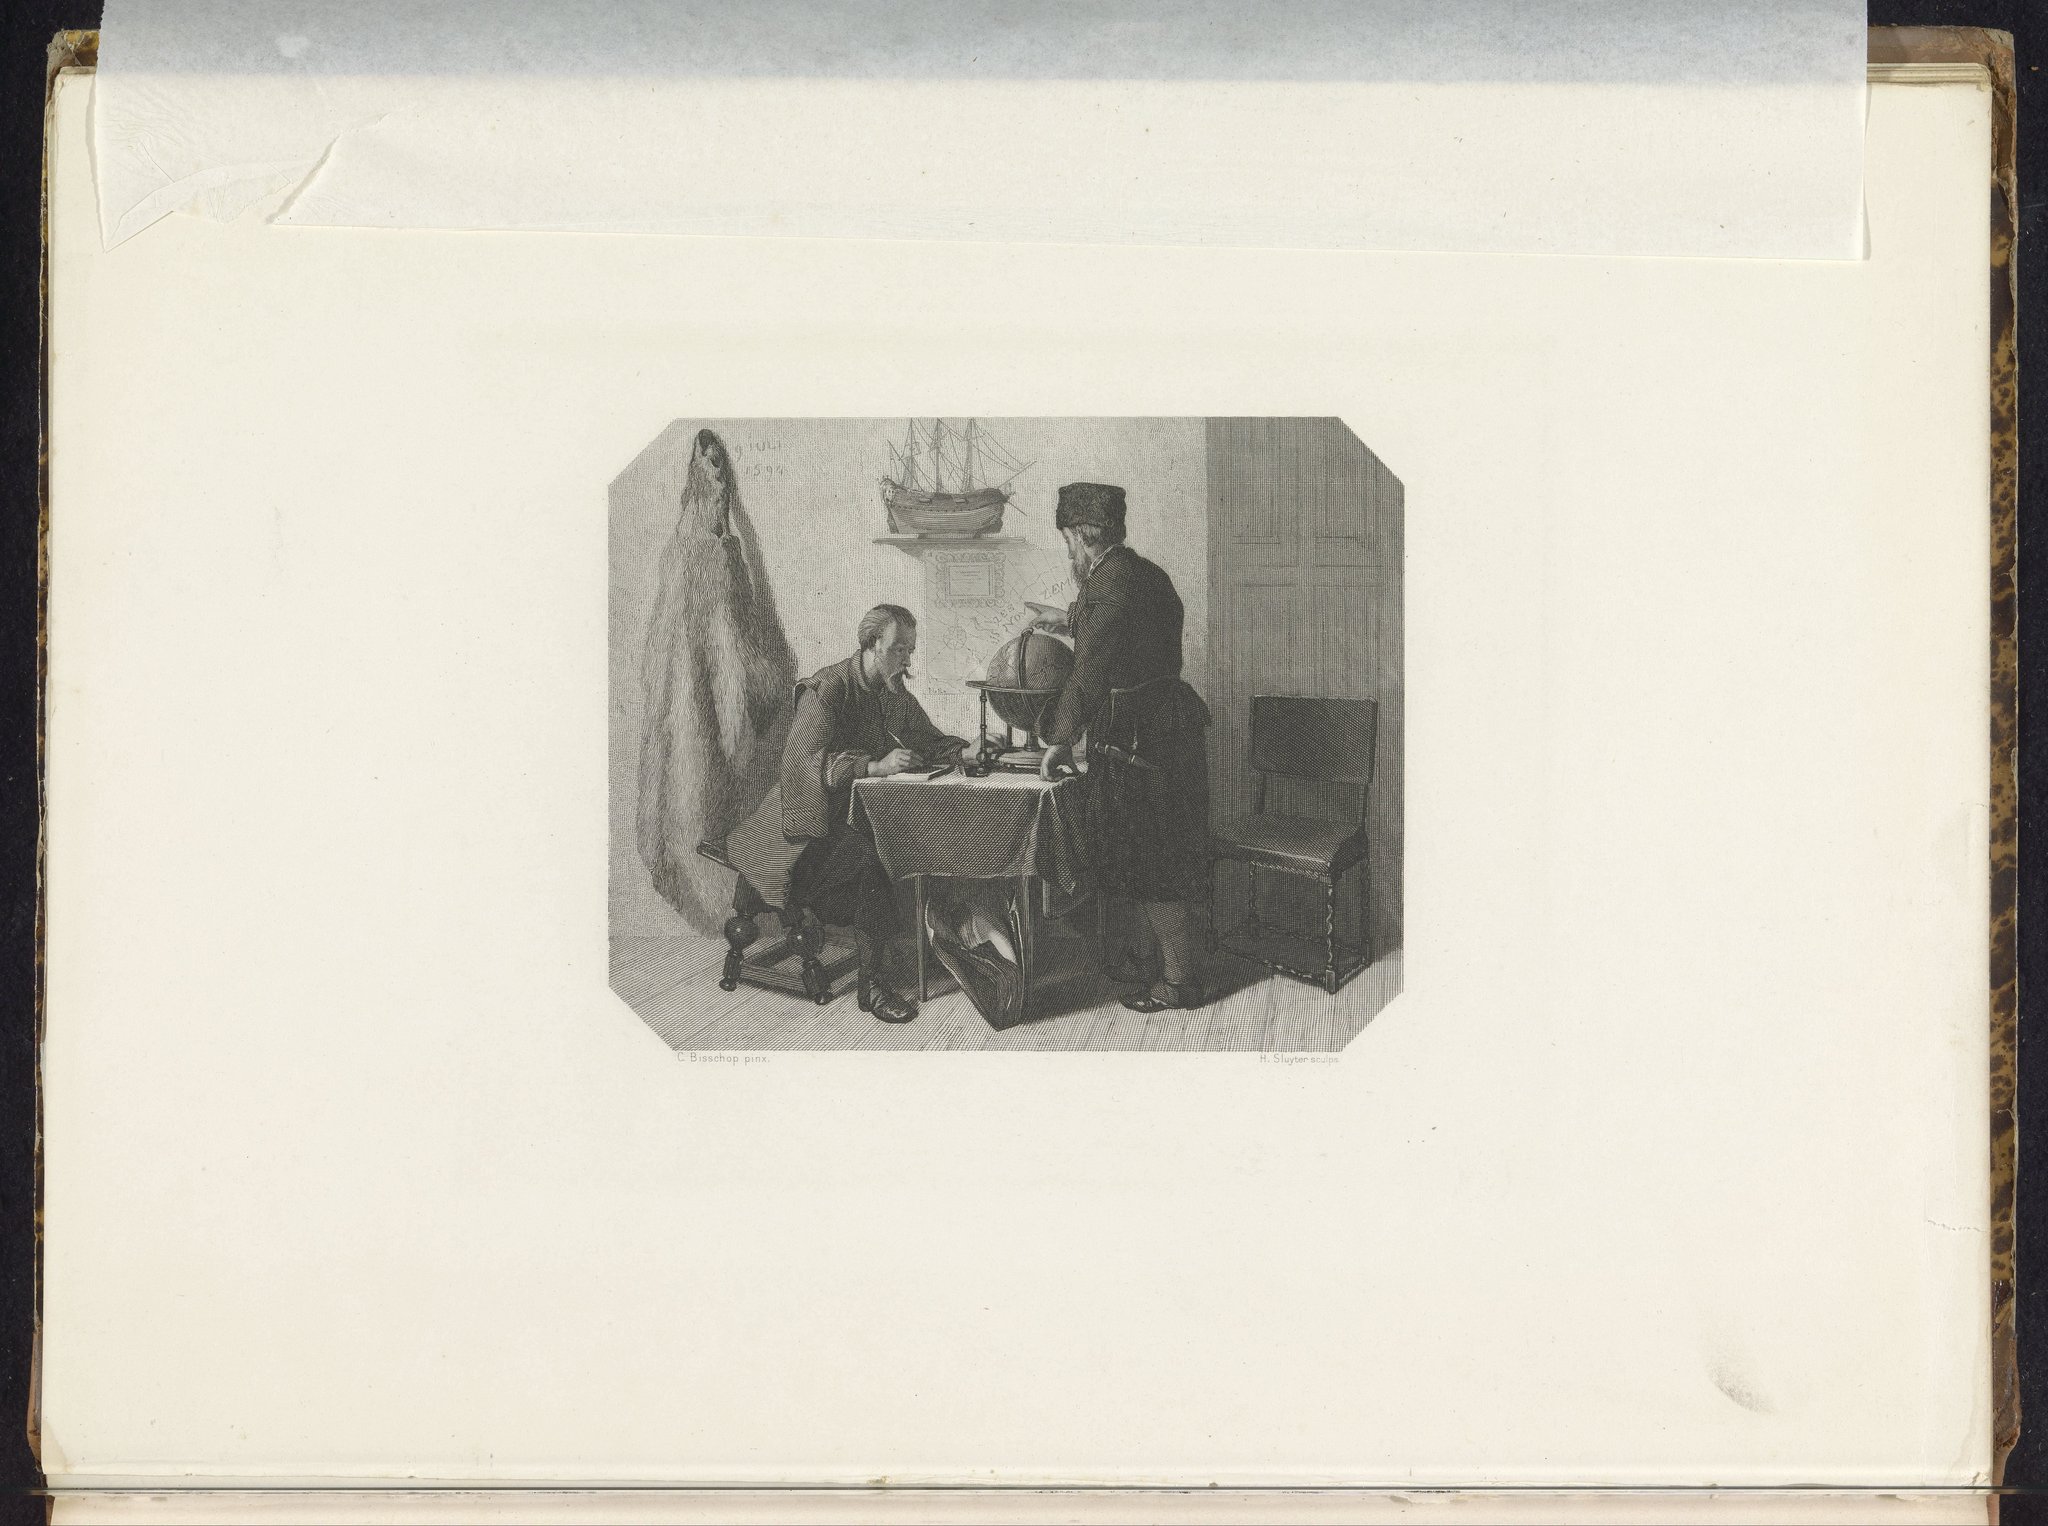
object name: print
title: Heemskerck en Barendsz bereiden hun derde tocht naar het Noorden voor, 1594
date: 1865-1870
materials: paper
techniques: engraving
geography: netherlands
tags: willem barendsz., amsterdam, jacob van heemskerck, scholar in his study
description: Jacob van Heemskerck en Willem Barendsz werken in een studeerkamer aan de voorbereidingen voor hun derde reis om een noordelijke doorvaart naar Indië te vinden; op de muur de datum 9 juli 1594. Onderdeel van de groep staalgravures naar de schilderijen van de Historische Galerij der Maatschappij Arti et Amicitiae.